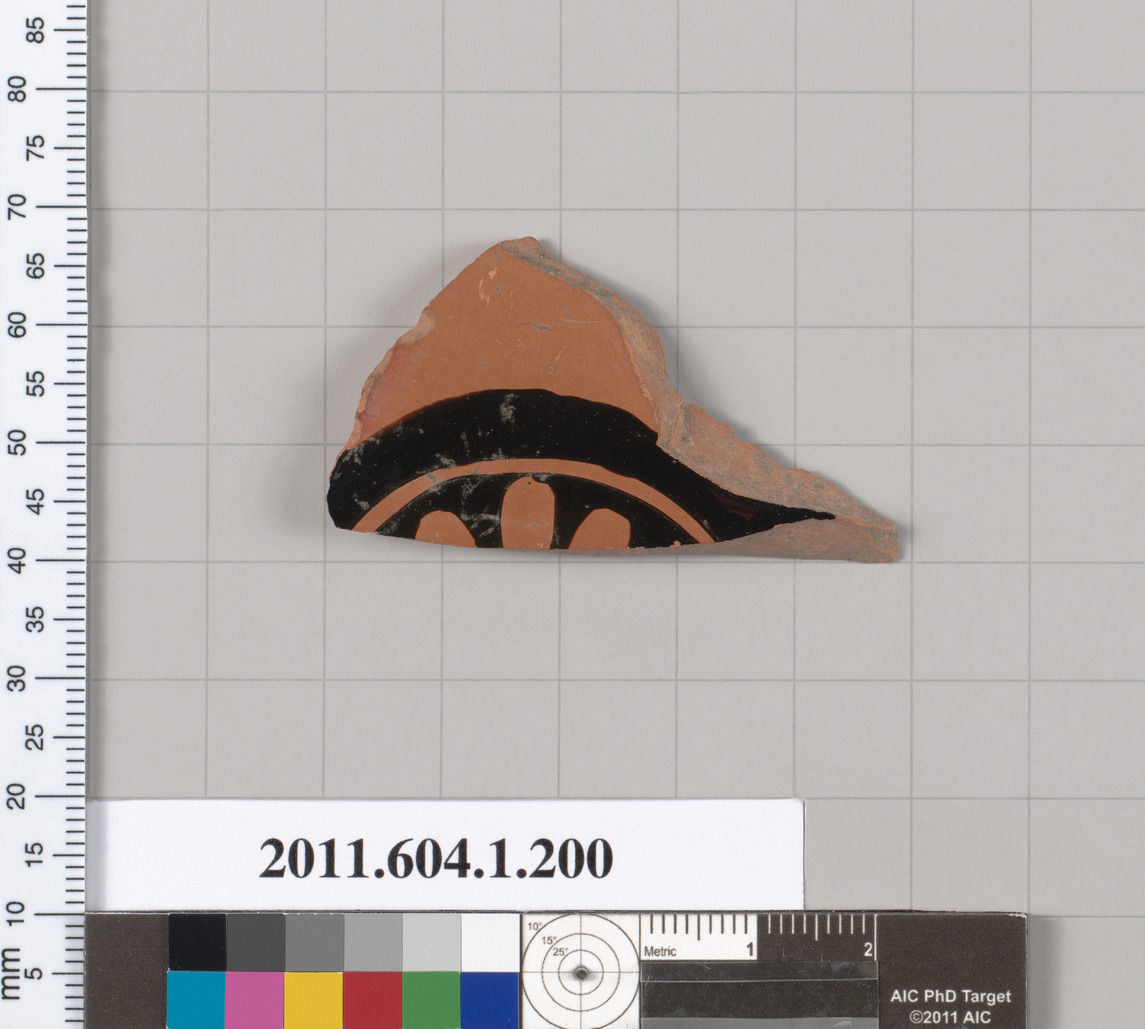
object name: kylix fragment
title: Terracotta fragment of a kylix (drinking cup)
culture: greek, attic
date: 475-451 BCE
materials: terracotta